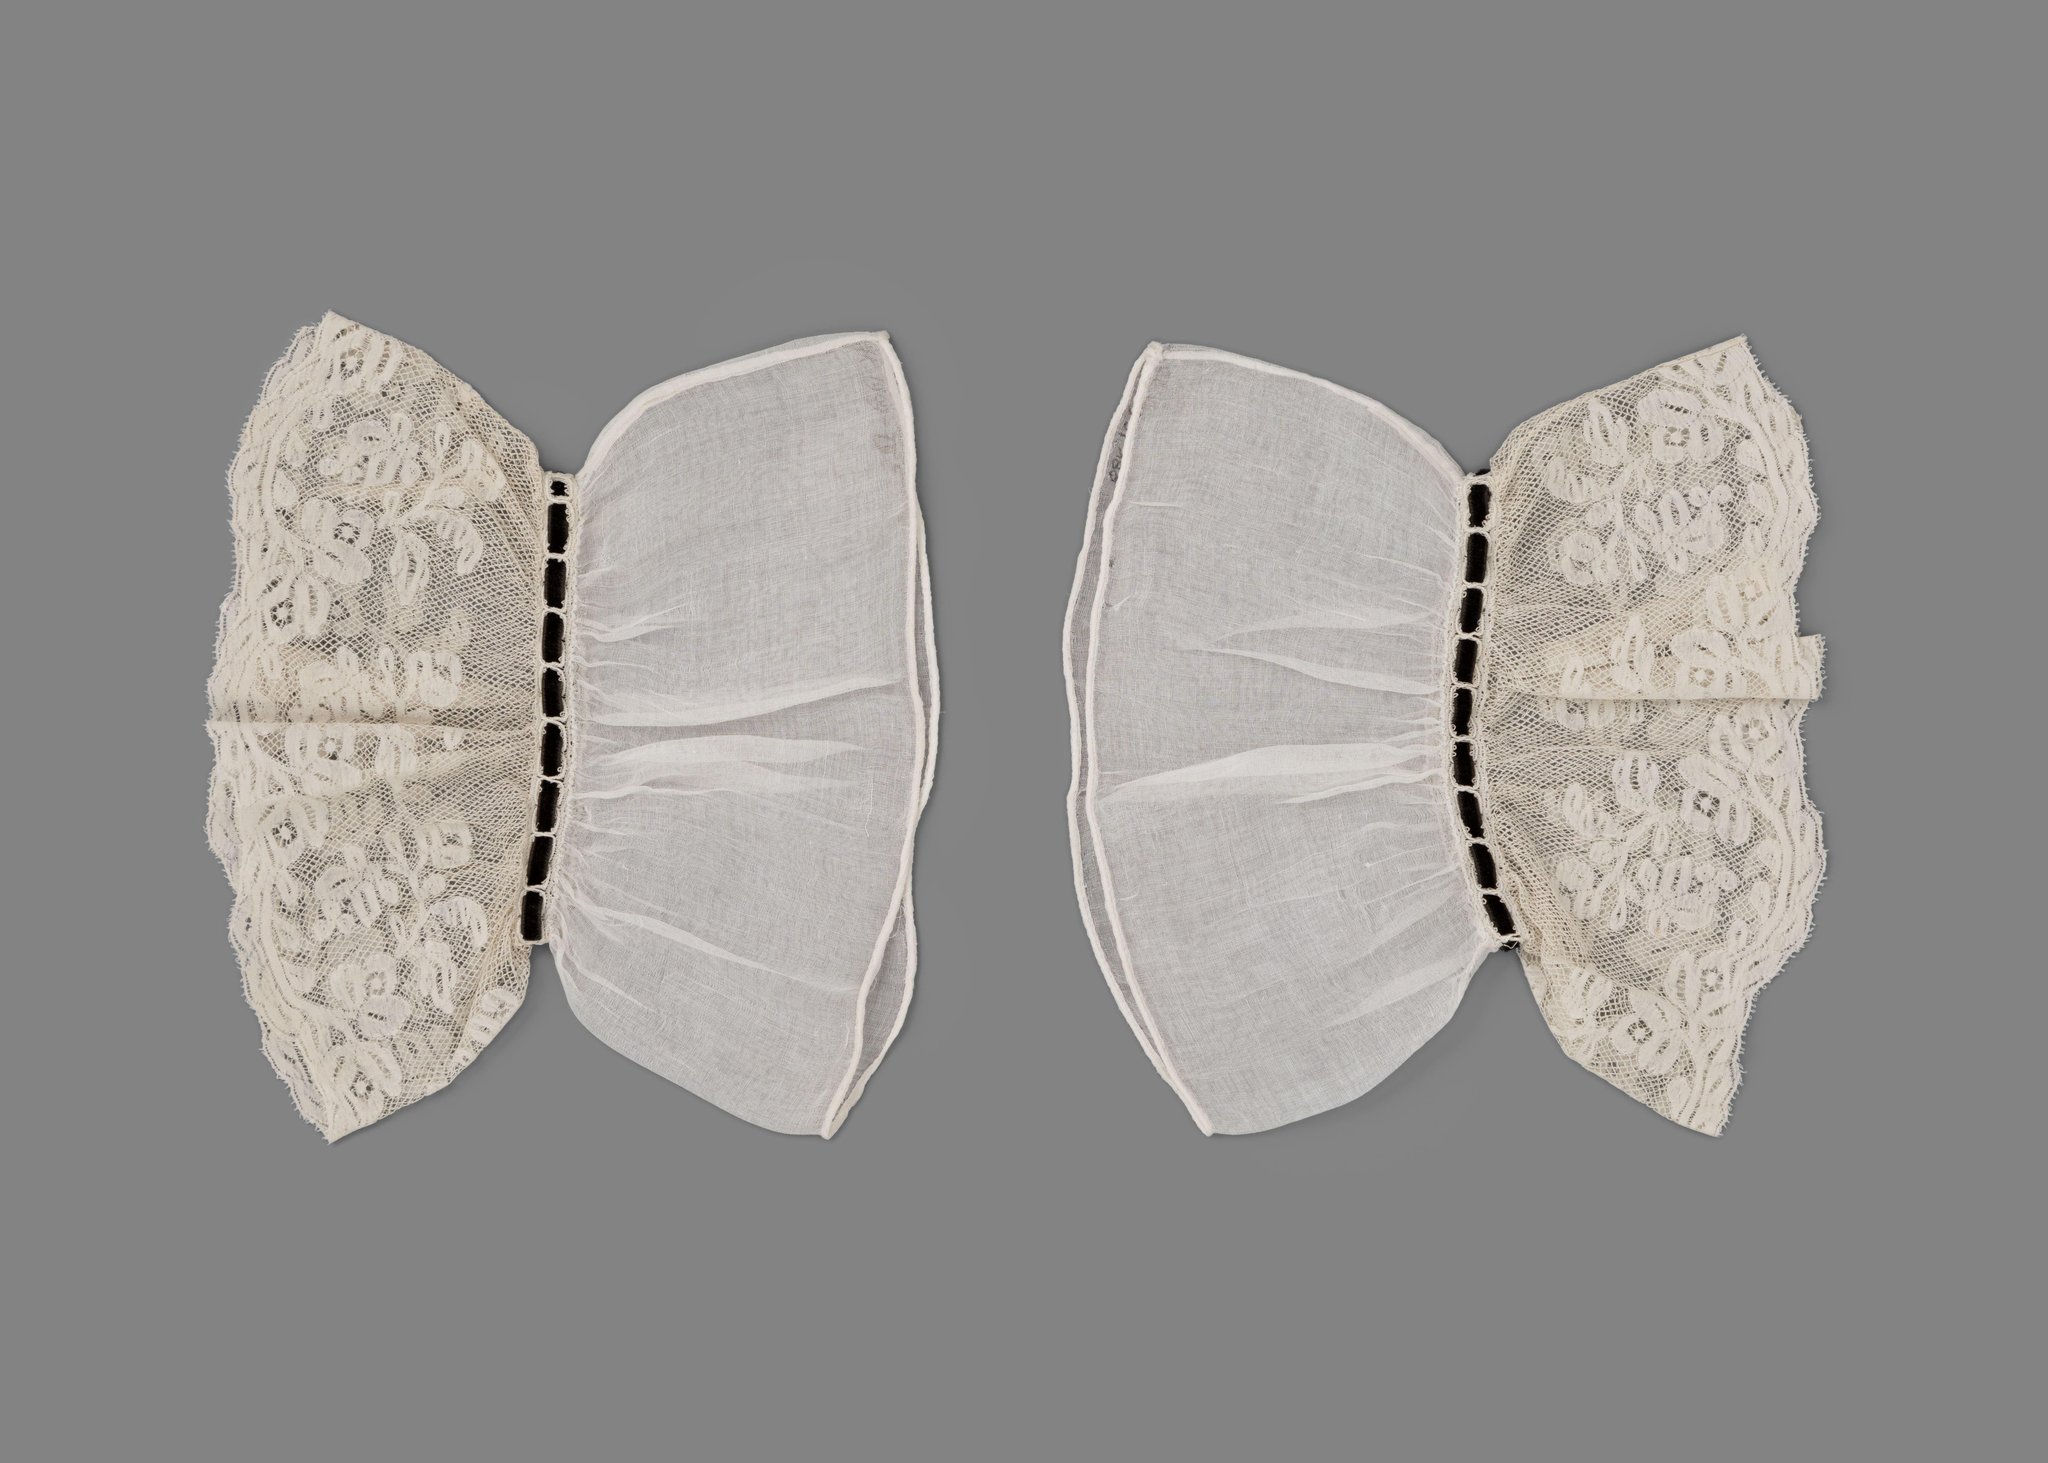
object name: undersleeve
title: Ondermouw van glasbatist met zwart lint fluweel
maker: Anonymous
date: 1885-1900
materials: velvet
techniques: cockled, lace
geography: netherlands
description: Paar ondermouw van glasbatist, en fluweetje met twee fragementen Valencinnes-Kloskant voor een kraag. Model. Korte coupe. Ingerimpeld bij de pols, waar een zwart fluweeltje ingeregen. Kanttechniek. Vierkante mazen. Linnenslagremplis zonder reliëf. Patroon. Brede, vlakke schulpen met in elk een eenzijdig gelopen volmit van een bebladerende tak met bloemen.